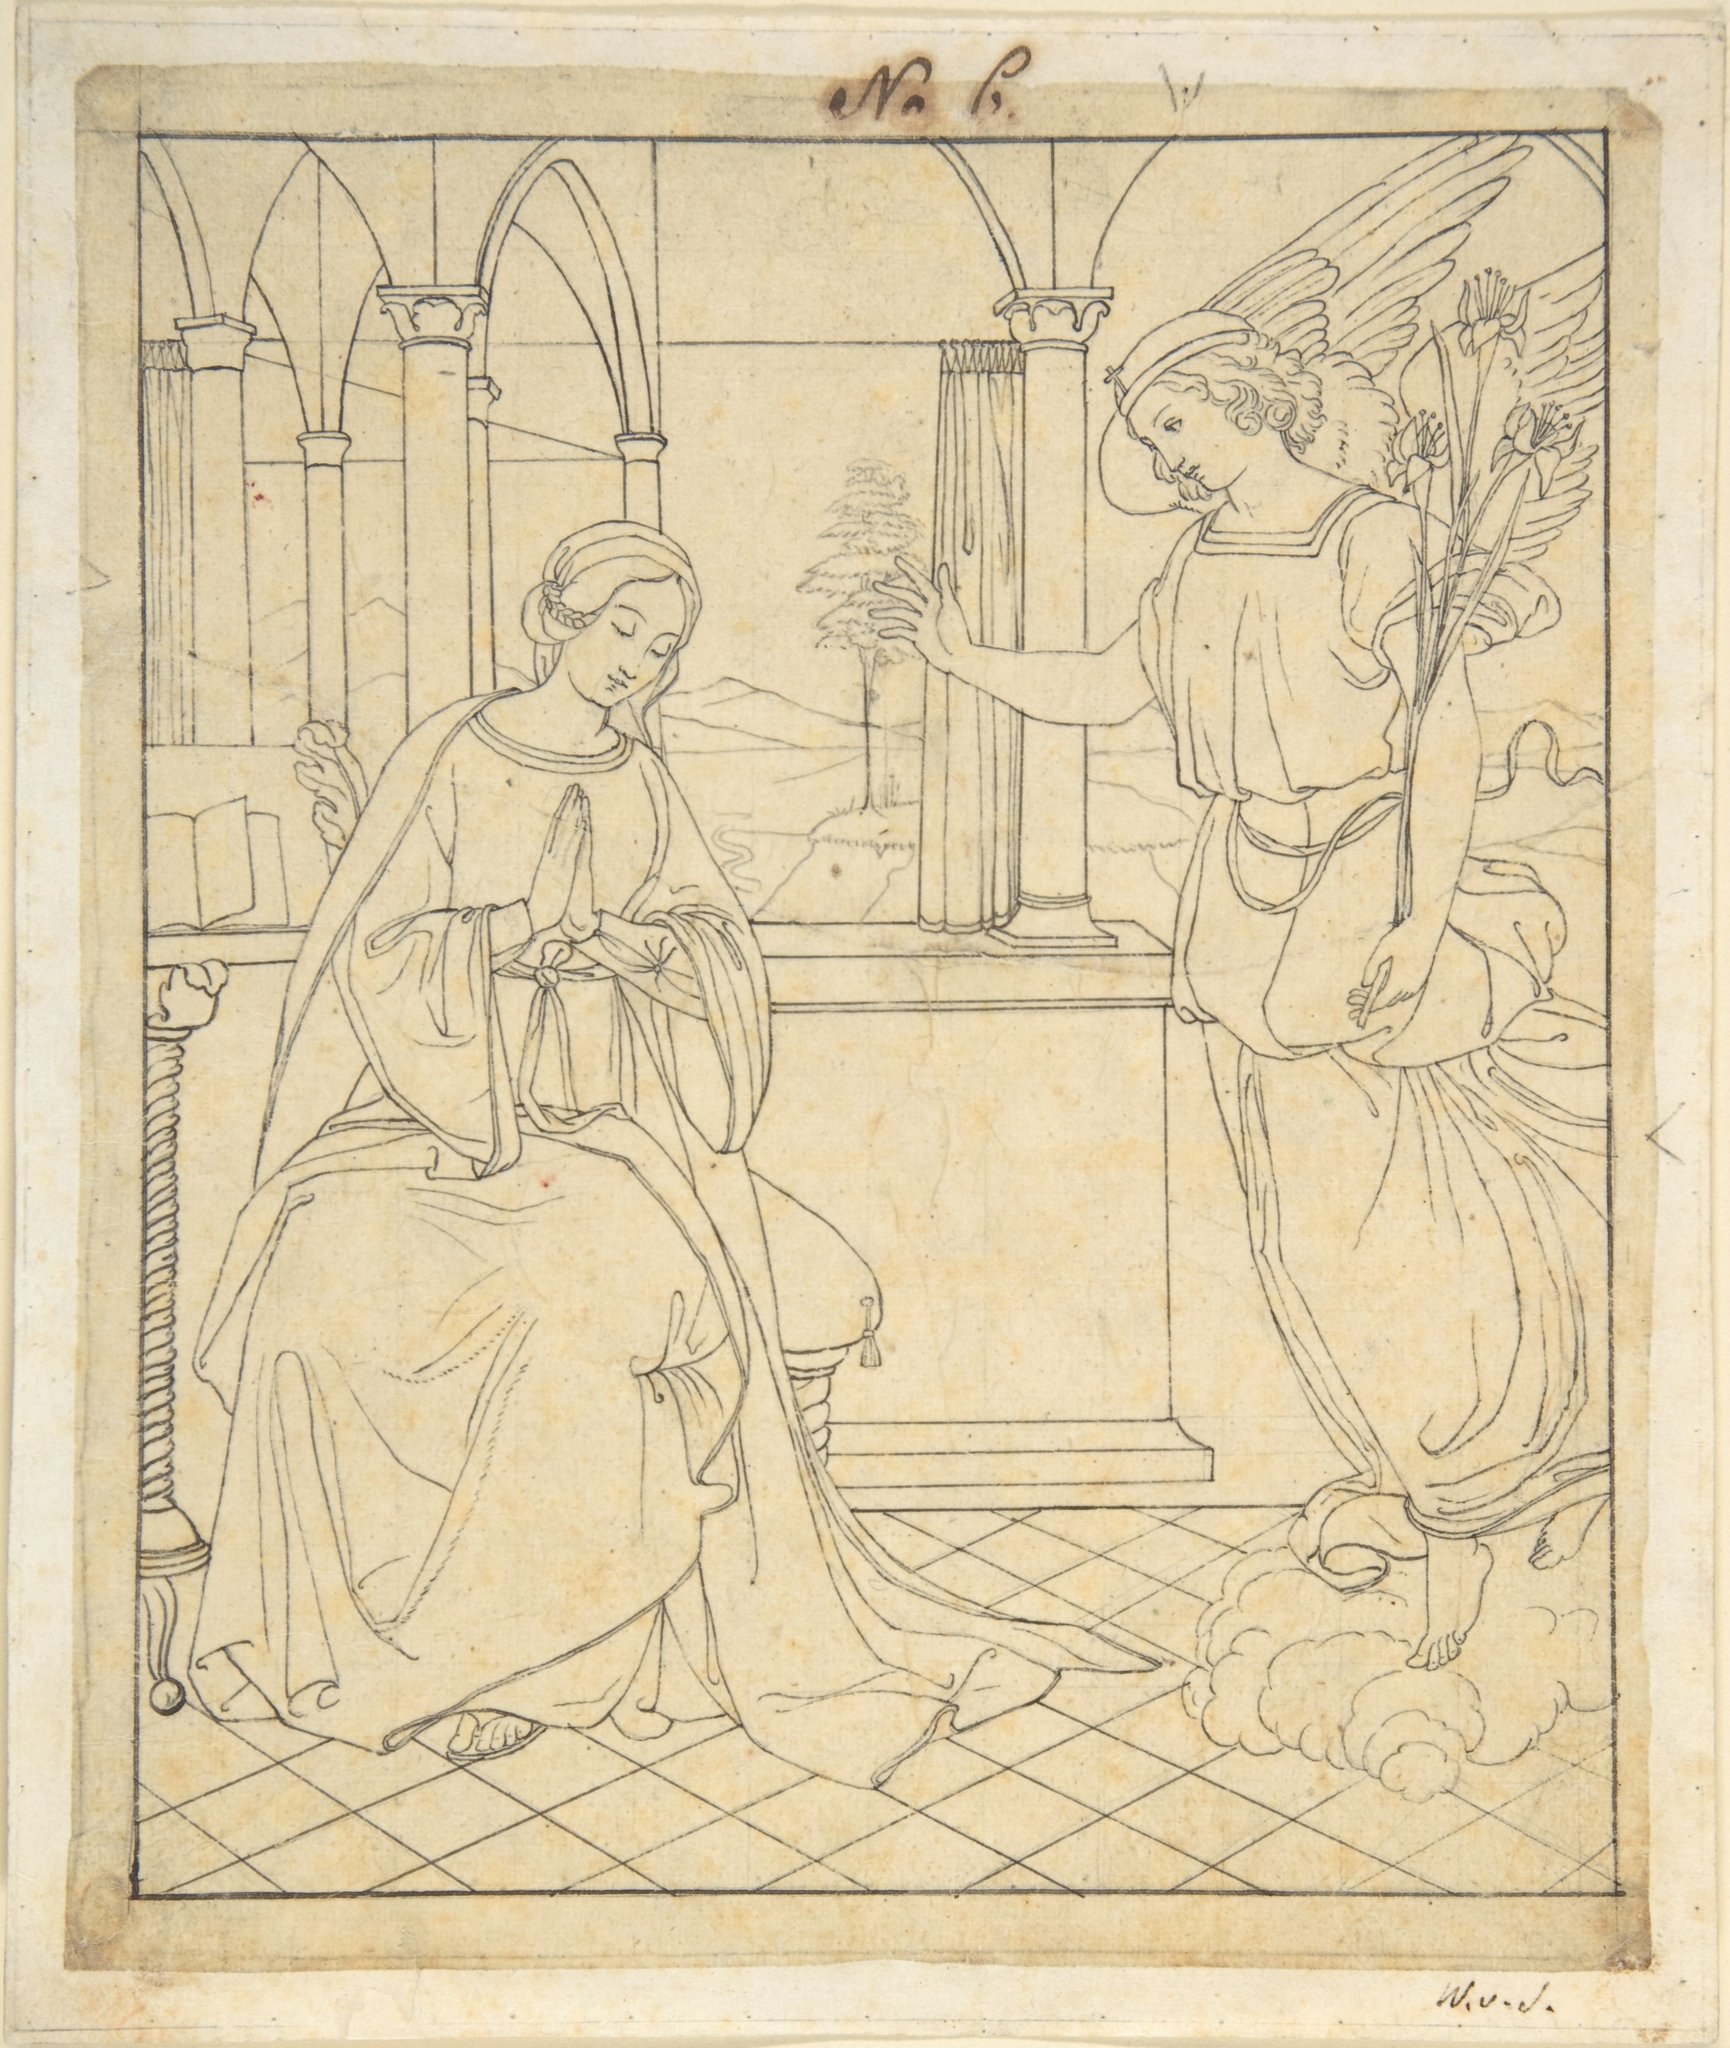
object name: drawing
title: The Annunciation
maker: wilhelm schadow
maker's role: artist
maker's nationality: german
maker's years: 1788-1862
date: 1808-1862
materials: ink, paper, parchment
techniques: pen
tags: virgin mary,archangel gabriel,annunciation